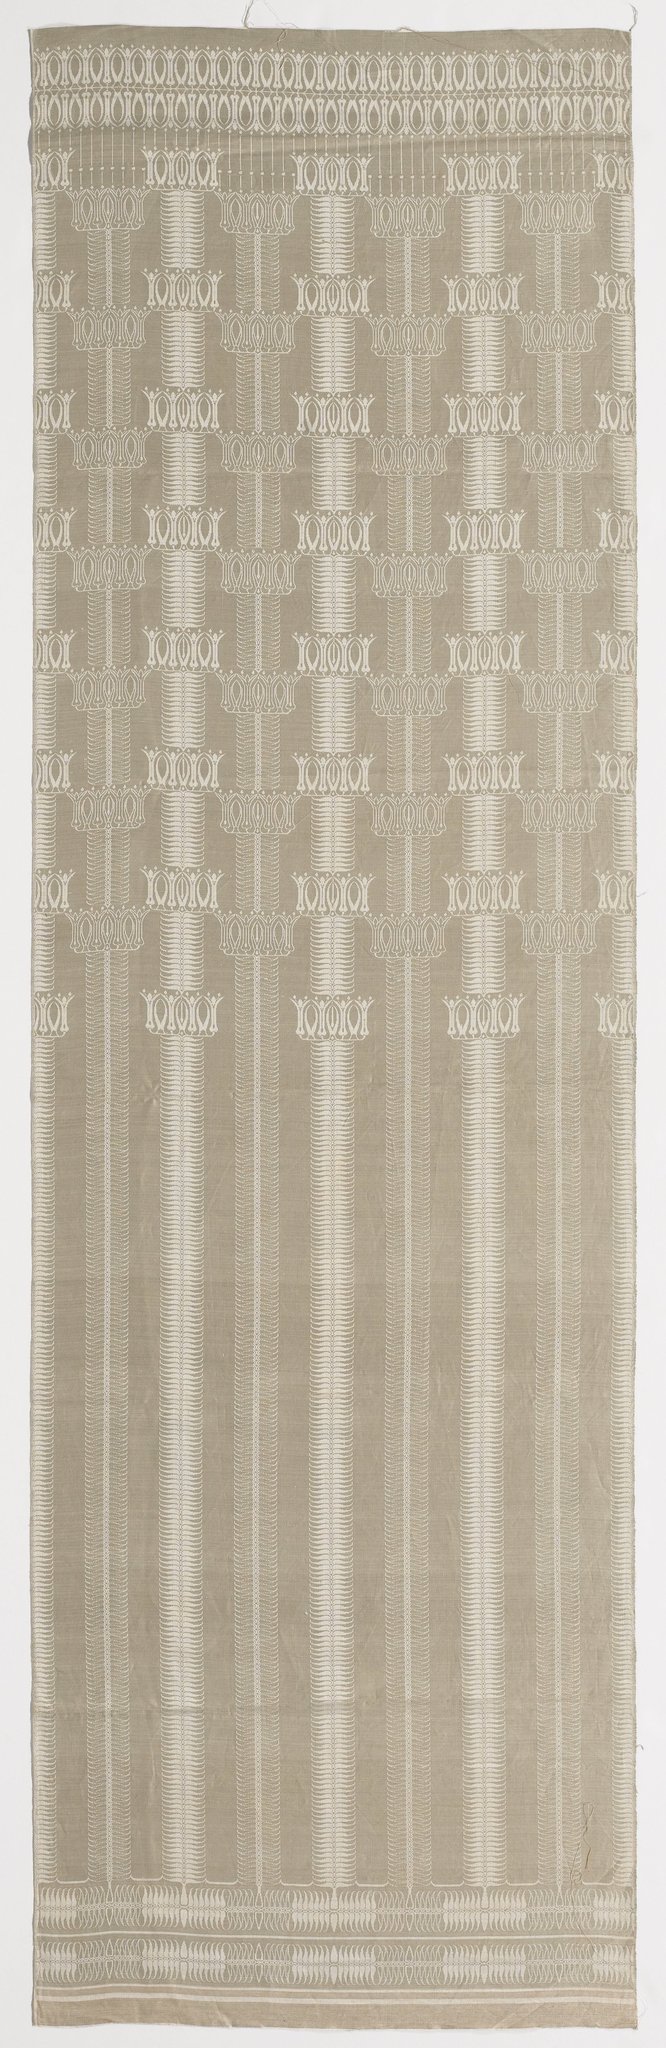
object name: upholstered wall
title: Wandbespanning met dessin van nagelbloemen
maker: chris lebeau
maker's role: draughtsman, print maker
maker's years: 1878-1945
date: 1911-1915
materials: linen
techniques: damask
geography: eindhoven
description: Beige-grijze damasten wandbespanning met een dessin van nagelbloemen. De onderste strepen zijn bruingrijs.